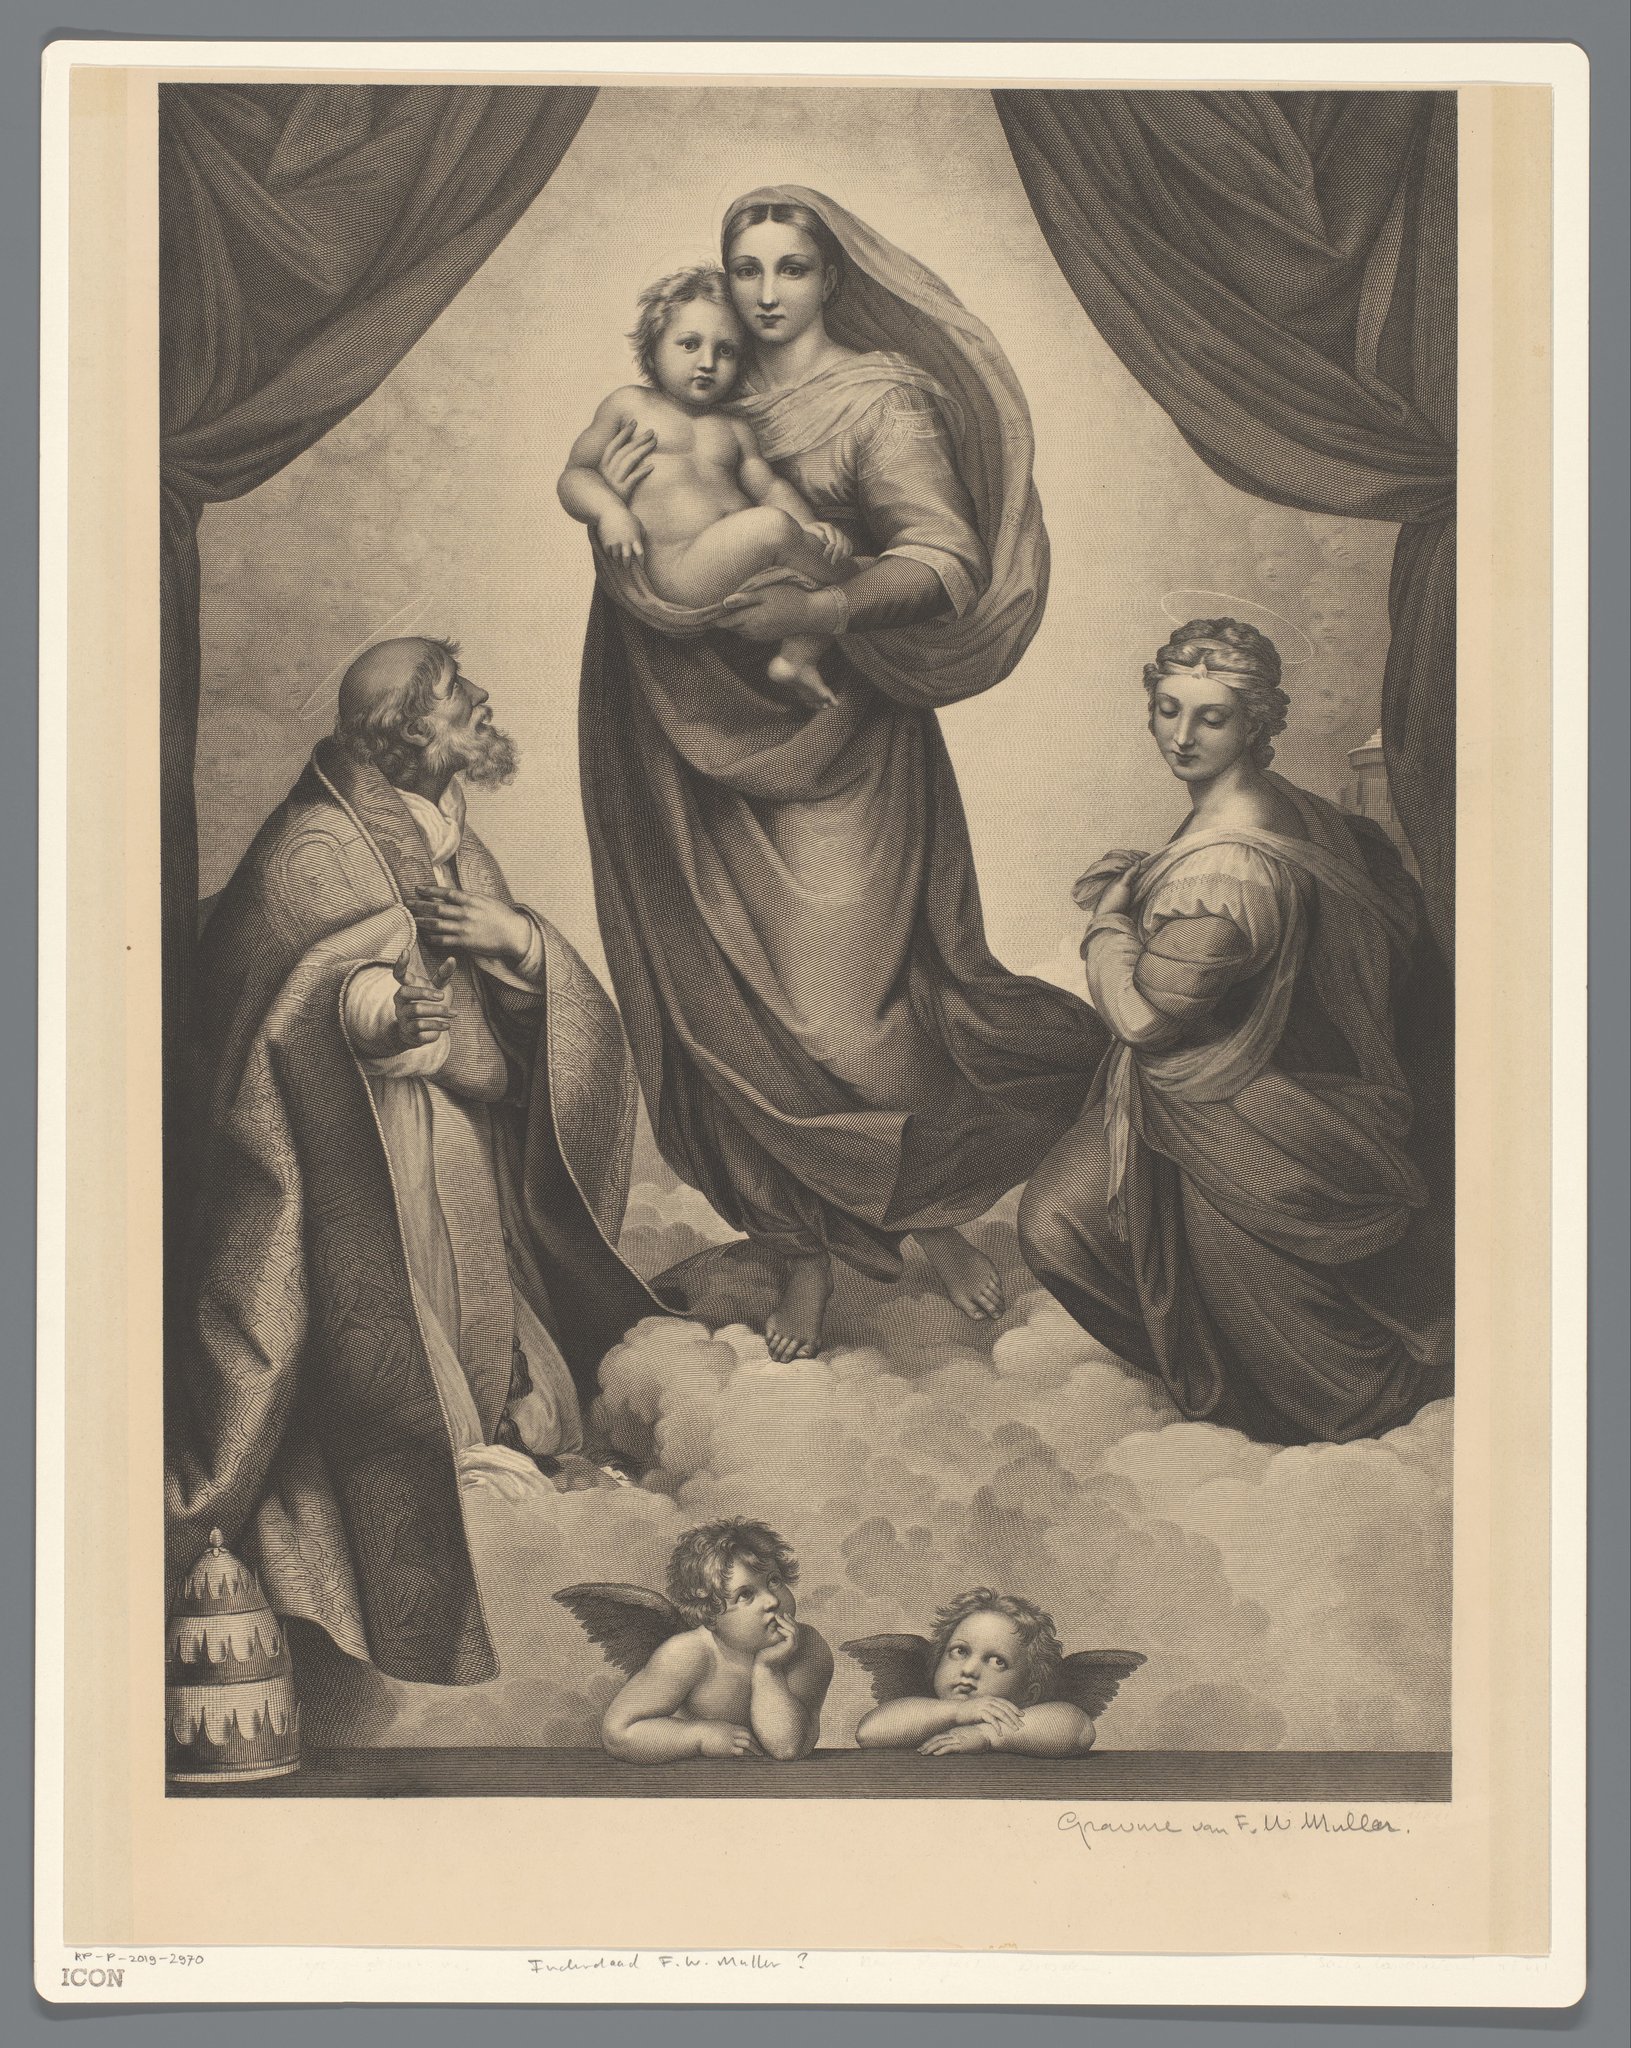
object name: print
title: Sixtijnse Madonna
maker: Anonymous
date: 1800-1899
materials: paper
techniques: engraving, etching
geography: germany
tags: 'sacra conversazione'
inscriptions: collector's mark: Lugt 2228, collector's mark: Lugt 4925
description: Het schilderij door Rafaël, ook bekend als de Sixtijnse Madonna, bevindt zich in de Gemäldegalerie Alte Meister in Dresden.